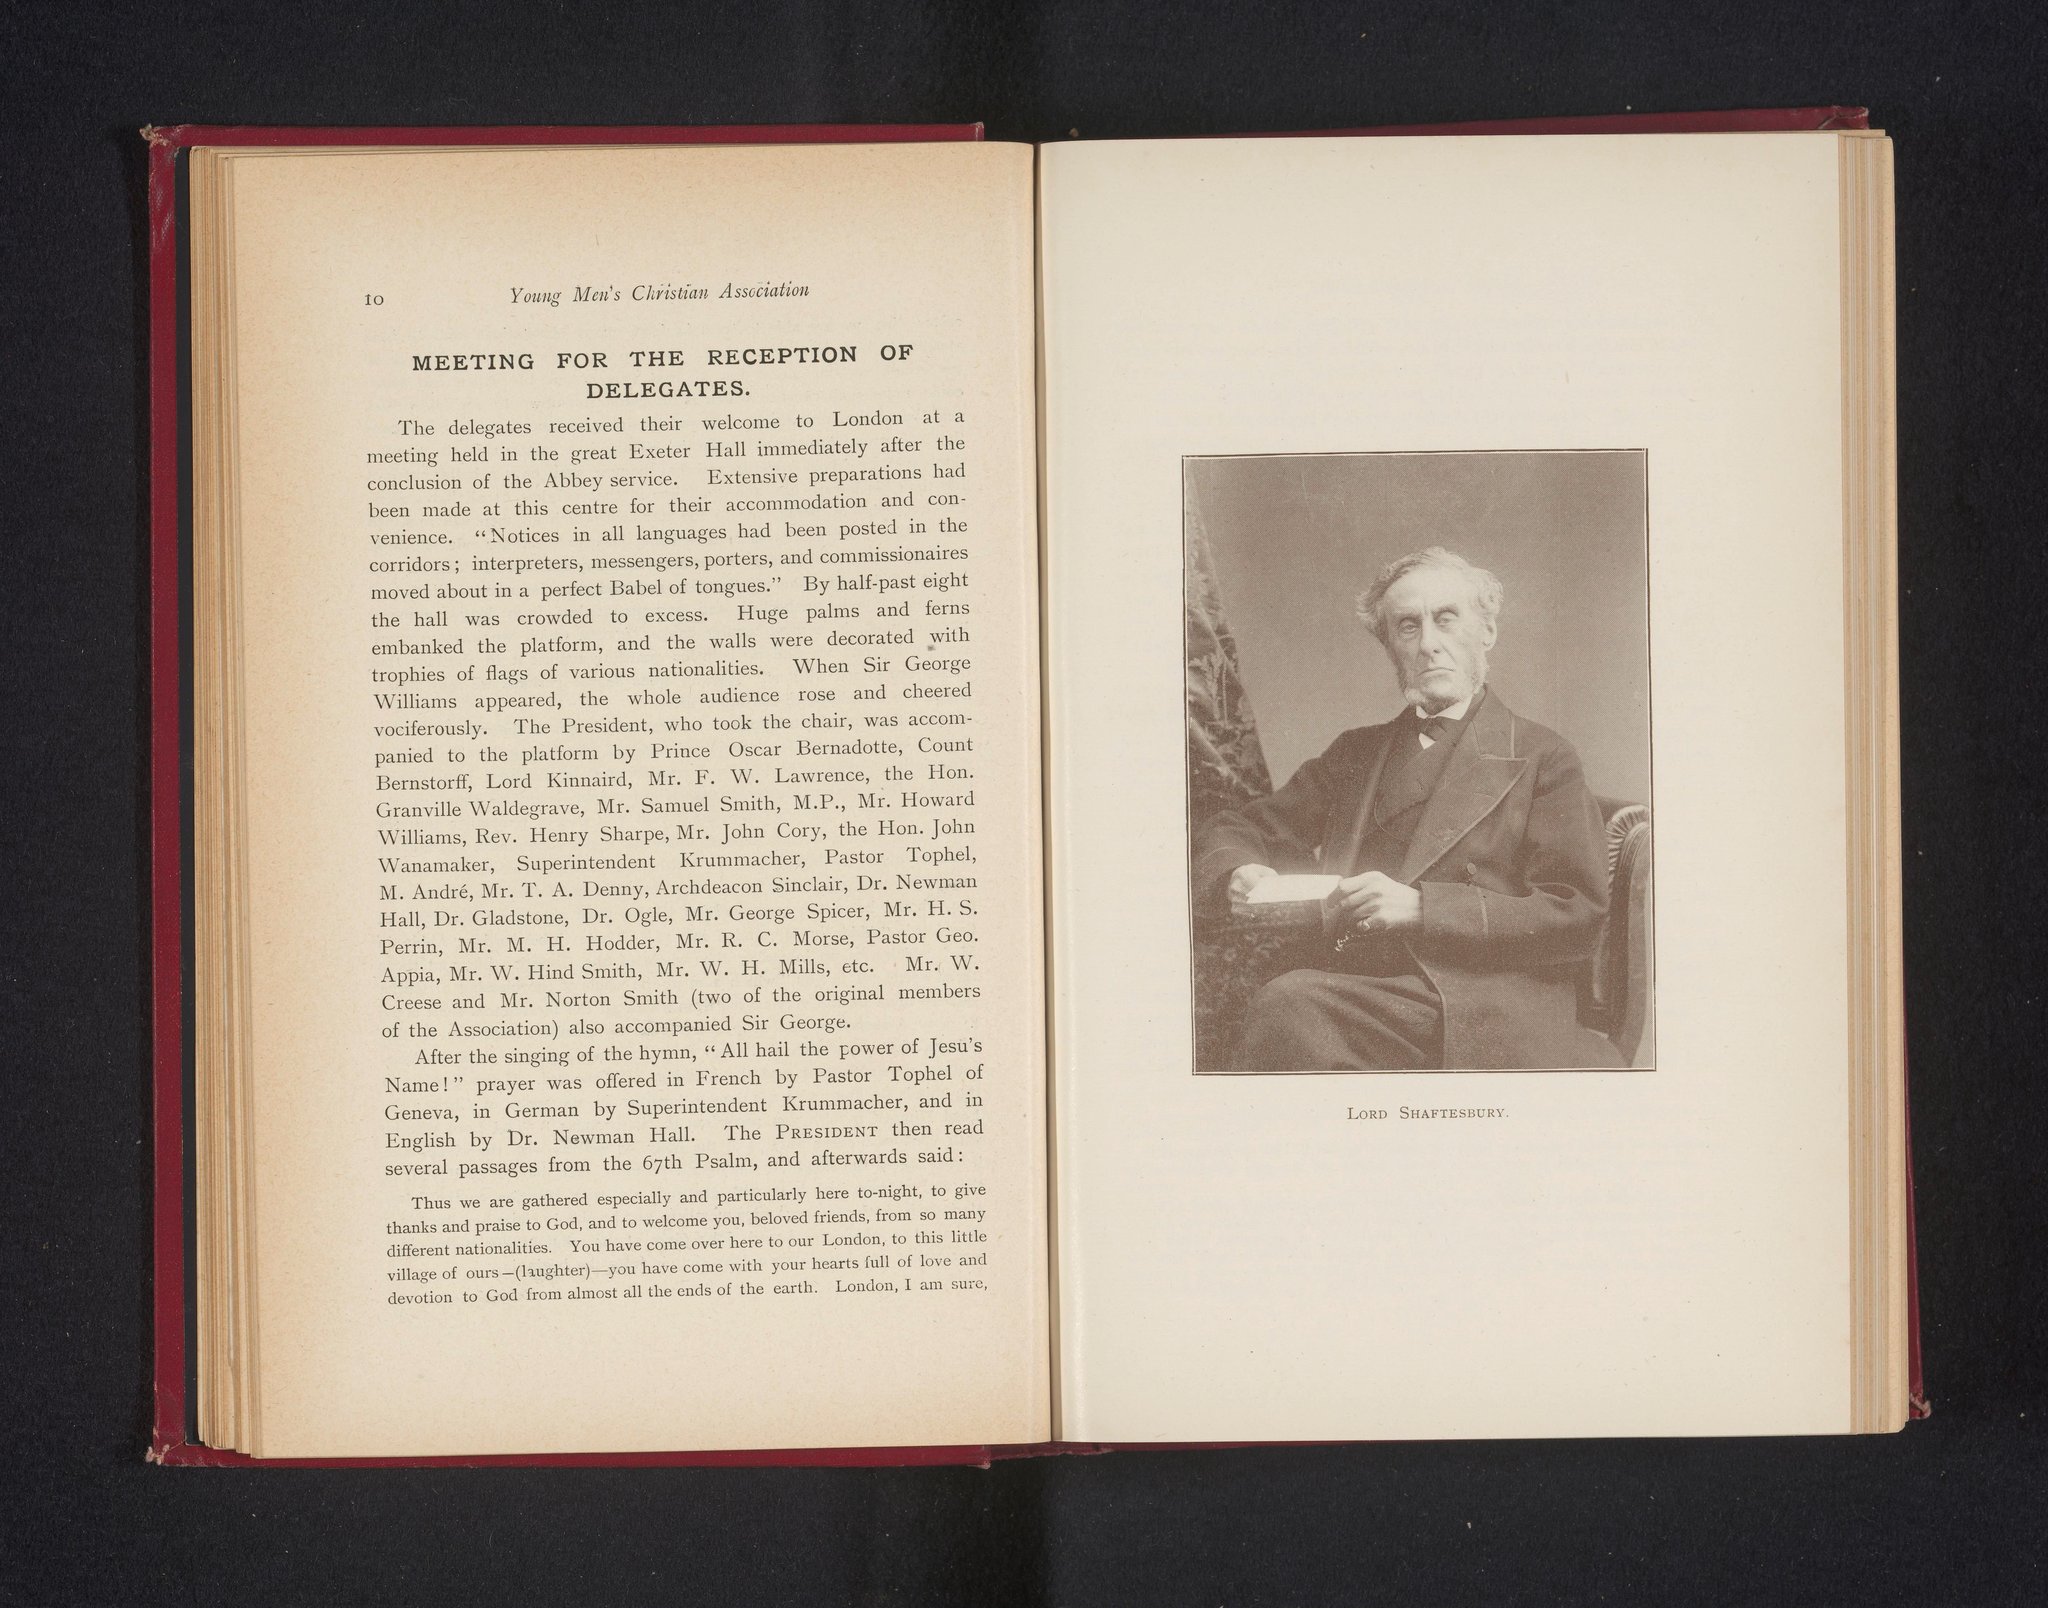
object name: photomechanical print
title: Lord Shaftesbury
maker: Anonymous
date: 1890-1895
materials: paper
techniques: autotype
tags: anthony ashley-cooper (7th earl of shaftesbury), historical persons